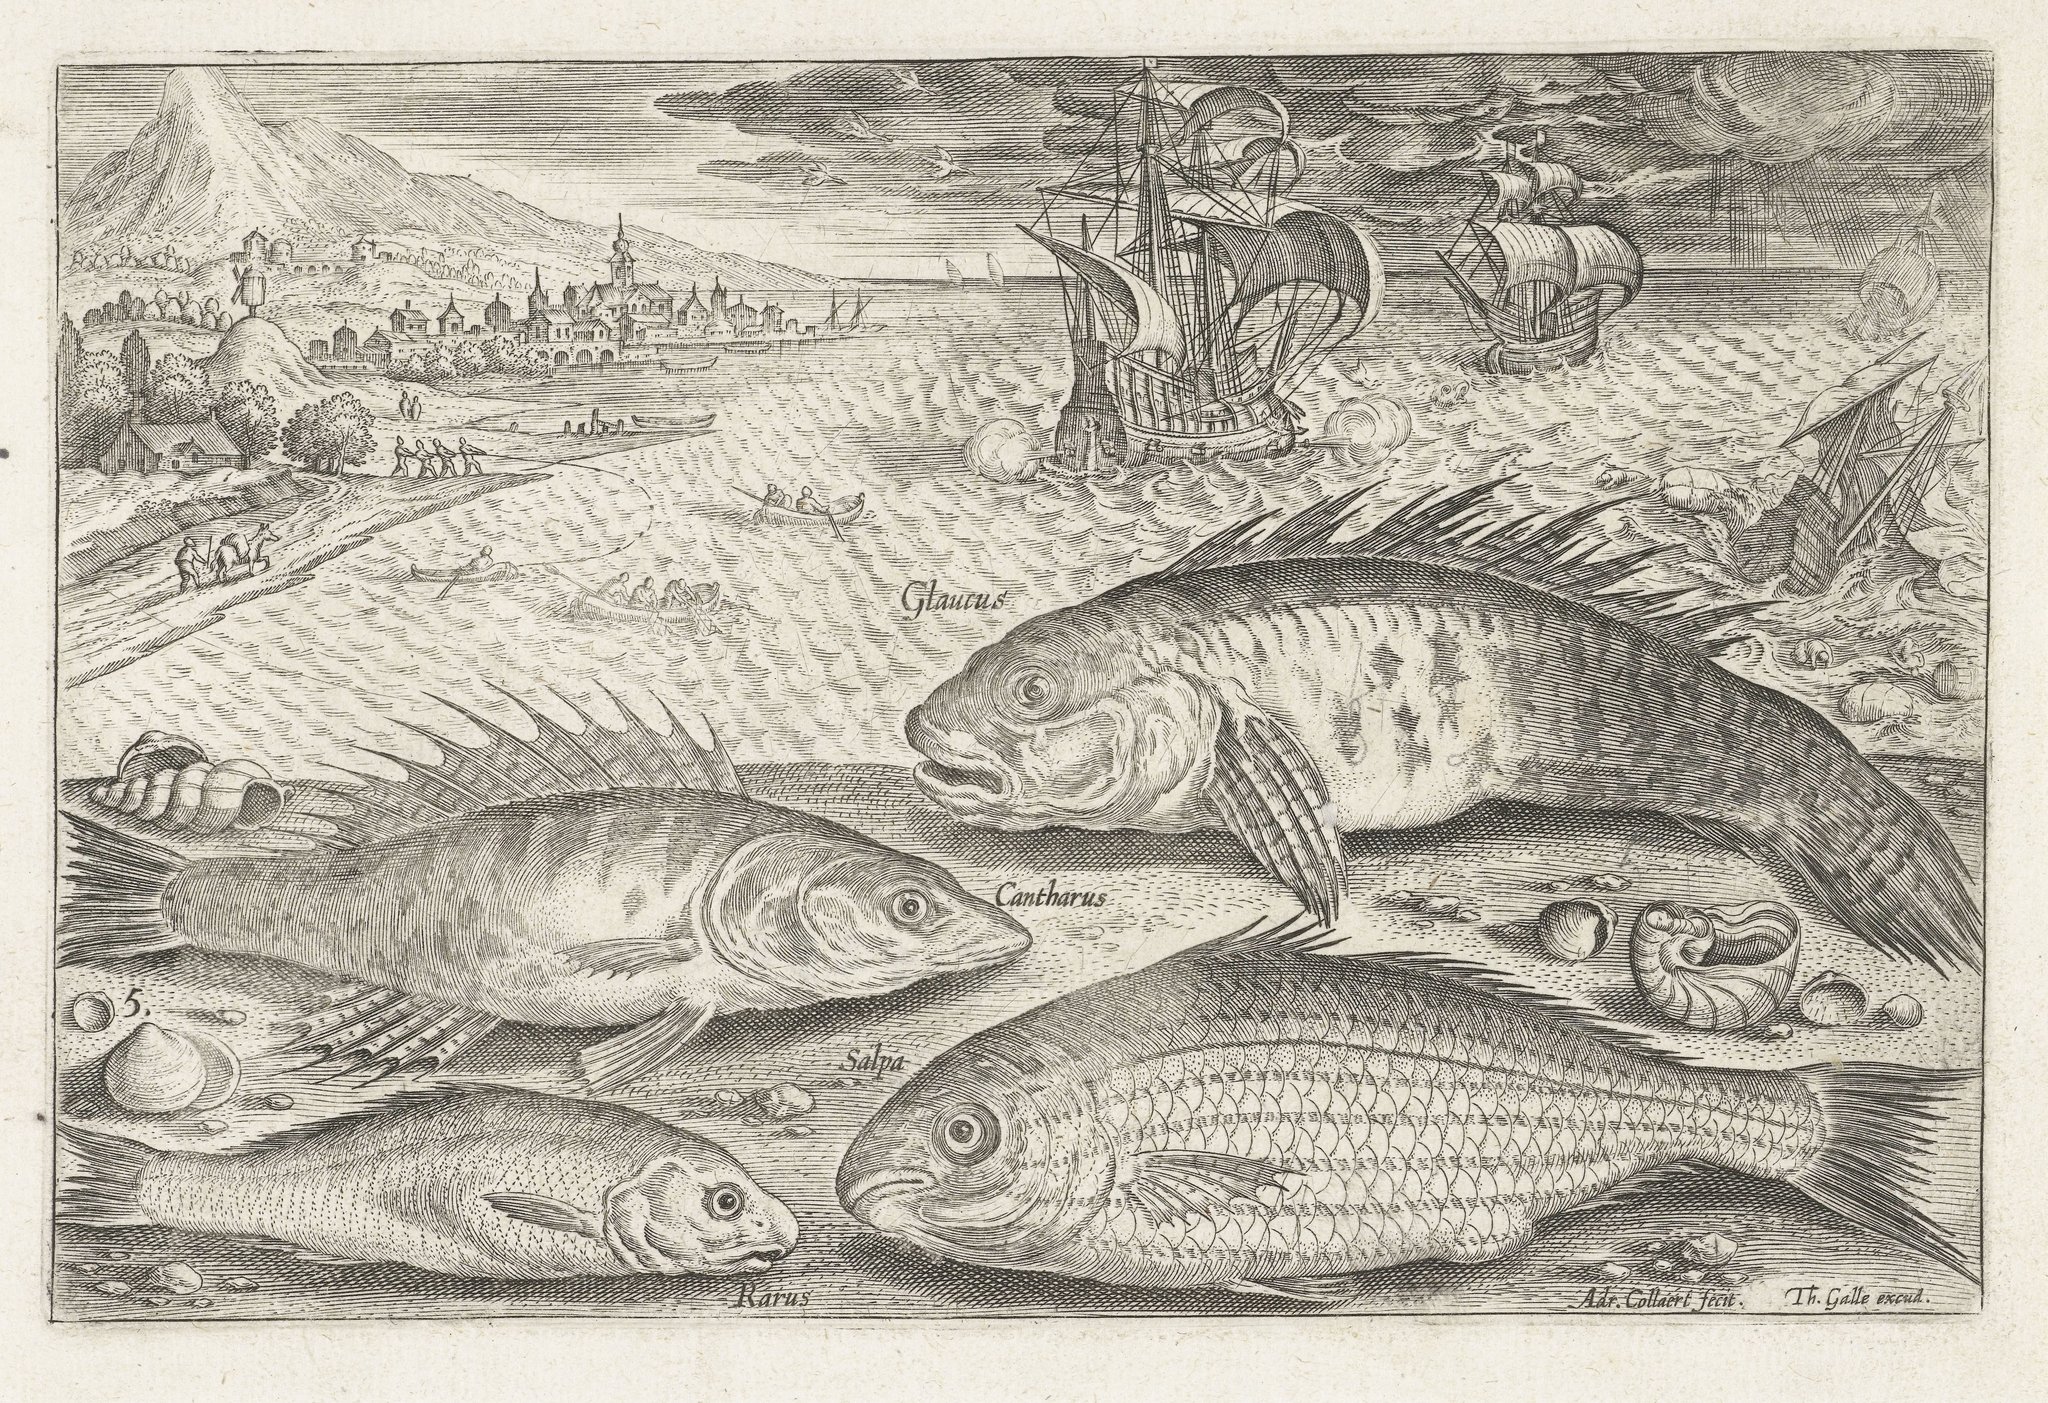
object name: print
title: Vissen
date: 1627-1636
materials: paper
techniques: engraving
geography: antwerp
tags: sea (seascape), bony fishes: sea-bream, bony fishes: salpa, bony fishes: goby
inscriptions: collector's mark: Lugt 2228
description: Een bokvis, een baars, een grondel en een onbekende vis liggen samen met wat schelpen aangespoeld op het strand. Op de achtergrond de zee met wat schepen. De prent maakt deel uit van een serie met vissen als onderwerp.